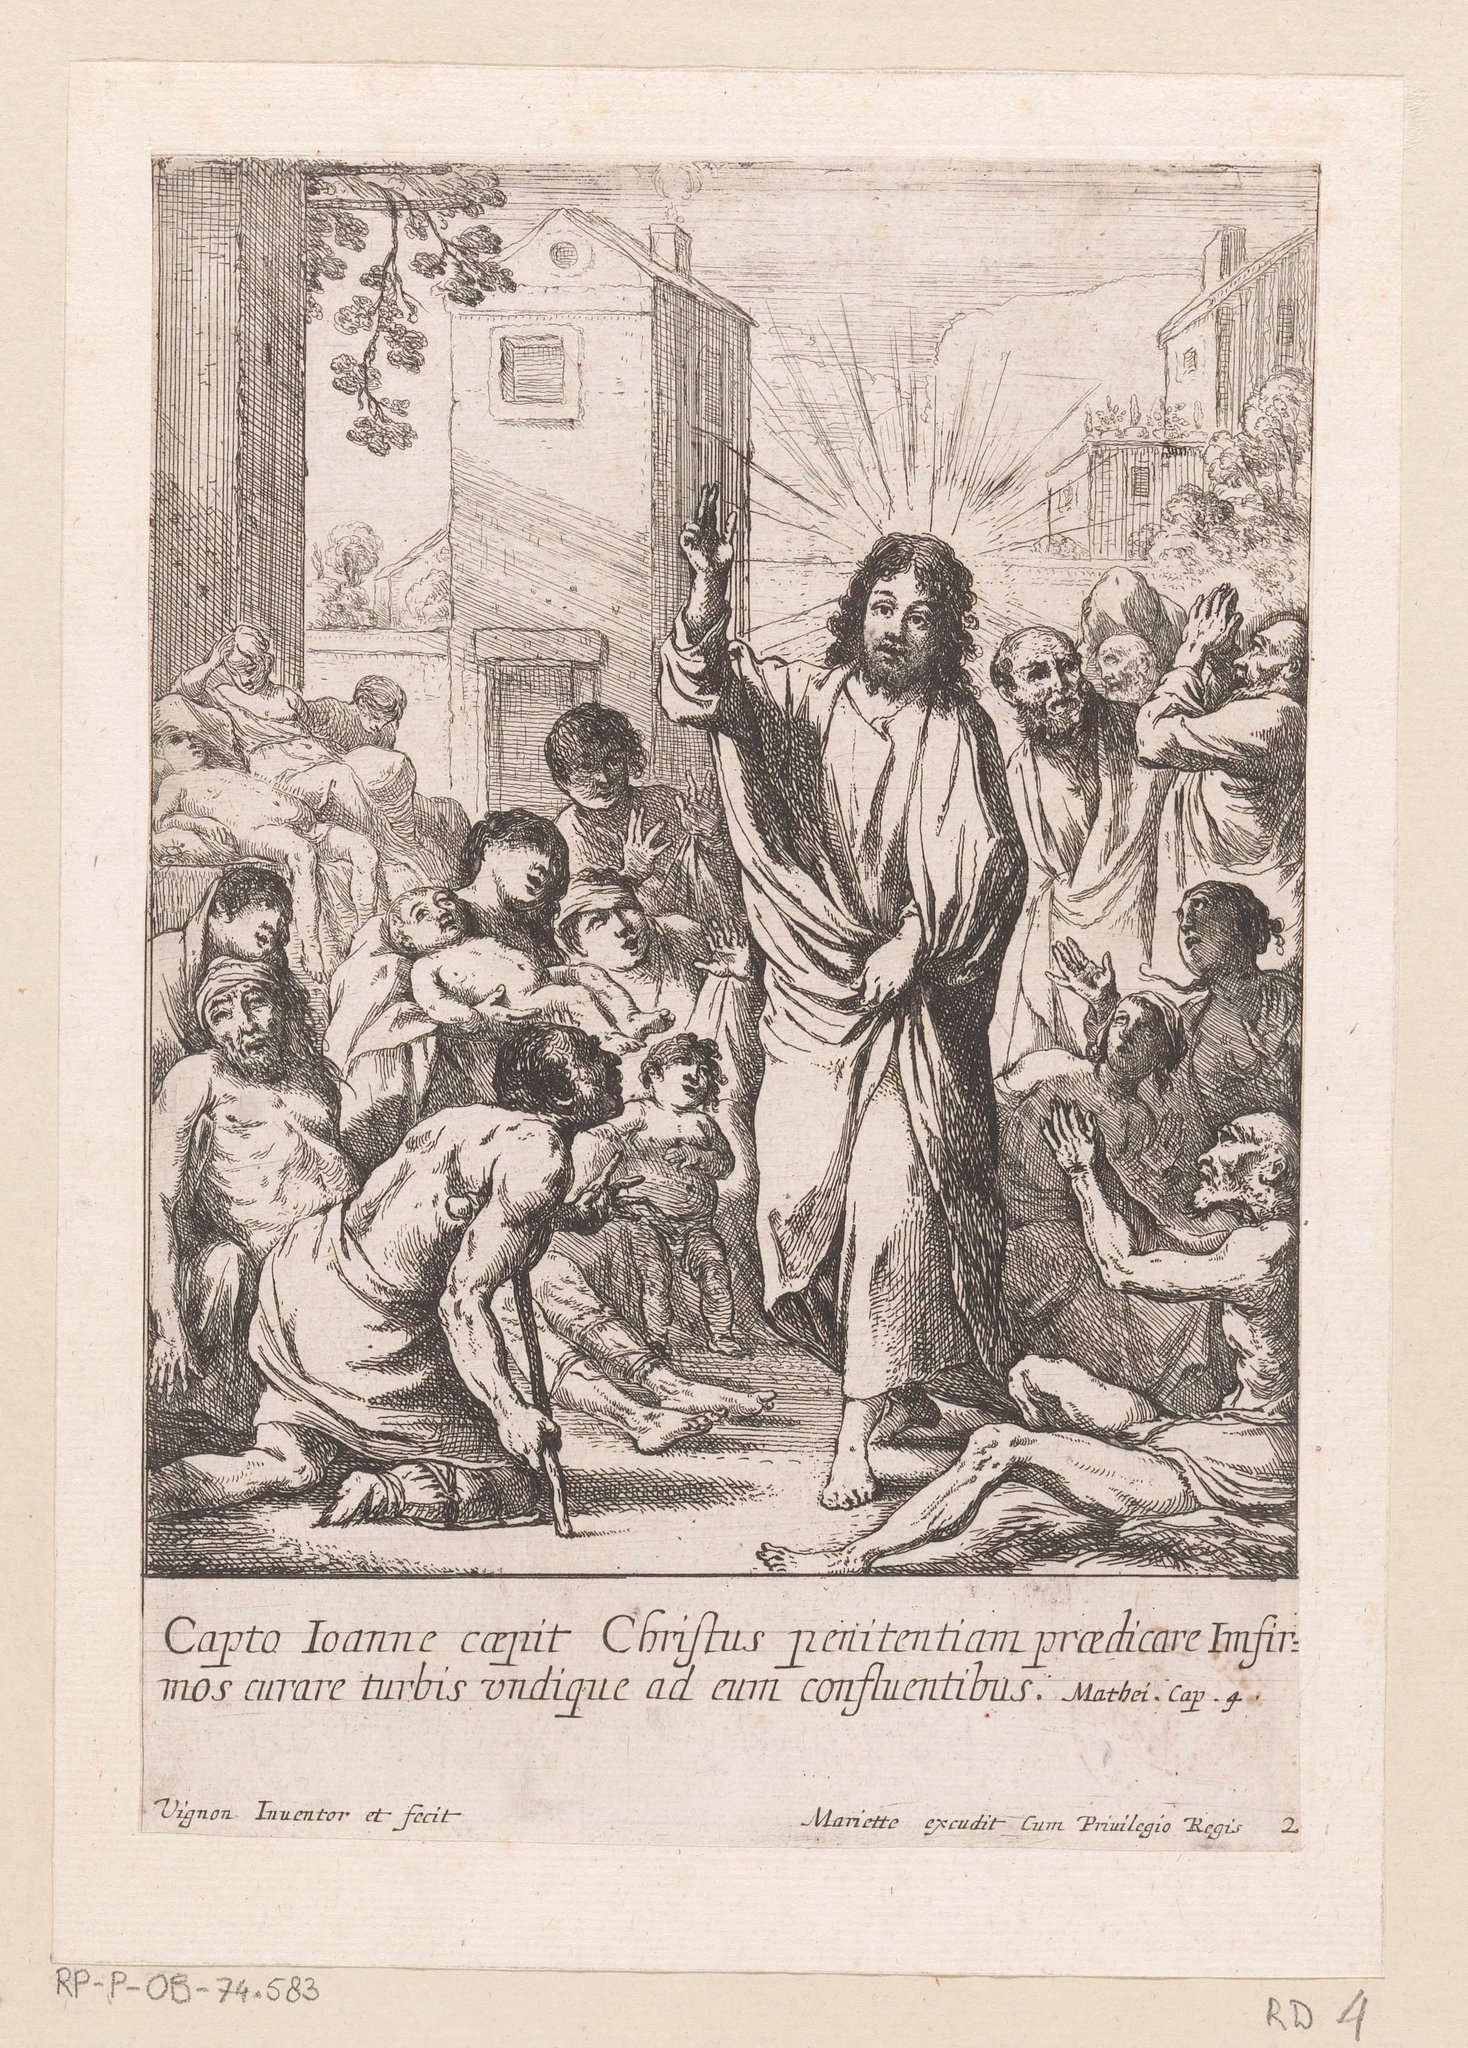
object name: print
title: Miracula Domini Nostri Jesu Christi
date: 1638-1643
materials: paper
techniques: etching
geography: paris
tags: miracles of christ ~ healing the sick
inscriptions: collector's mark: Lugt 240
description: Maakt deel uit van een serie van dertien prenten voorstellende de wonderen van Christus, opgedragen aan de arts Charles Delorme (1584-1678).